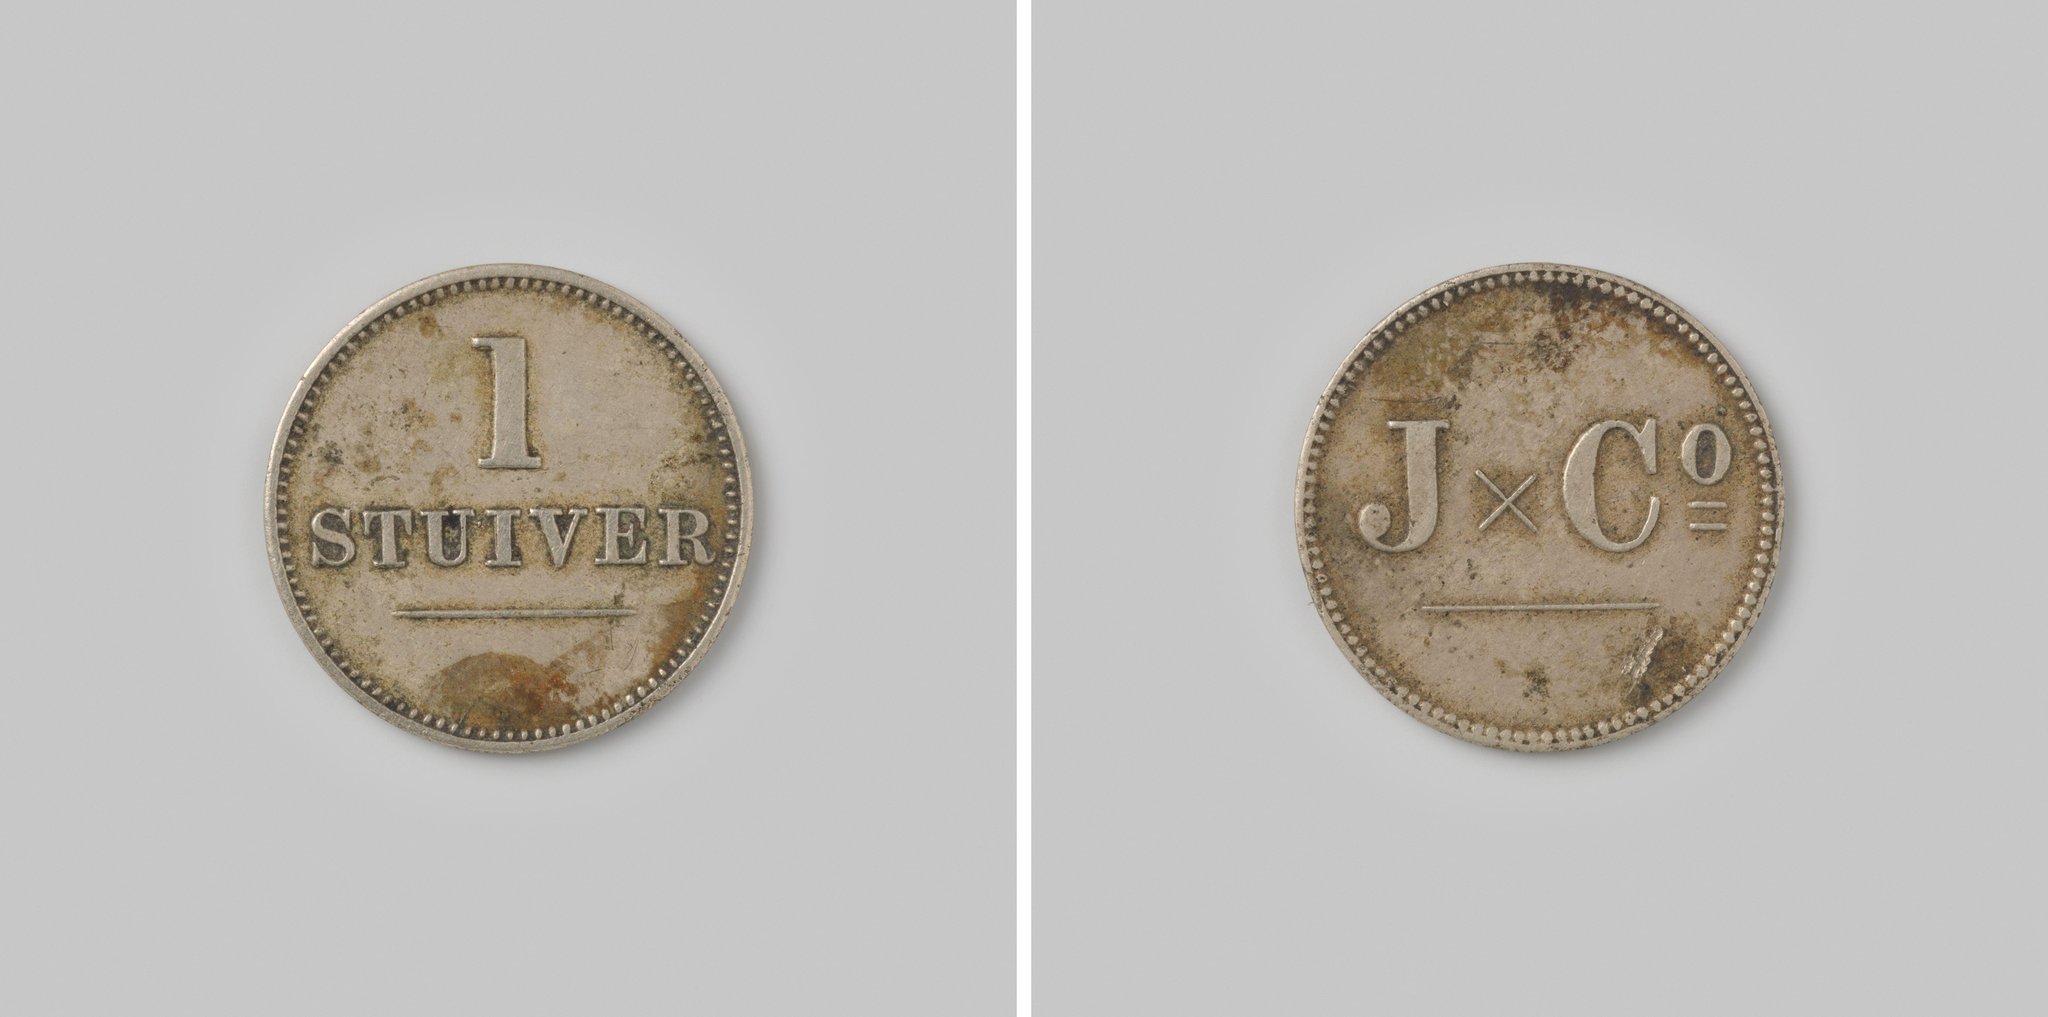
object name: coin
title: Curacao, particuliere stuiver van de firma Jesurun & Co., ca. 1880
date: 1875-1885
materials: nickel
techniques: striking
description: Nikkelen particuliere munt. Voorzijde: in twee regels waarde-aanduiding. Keerzijde: op eeen regel aanduiding van de particukliere firma: J x Co.